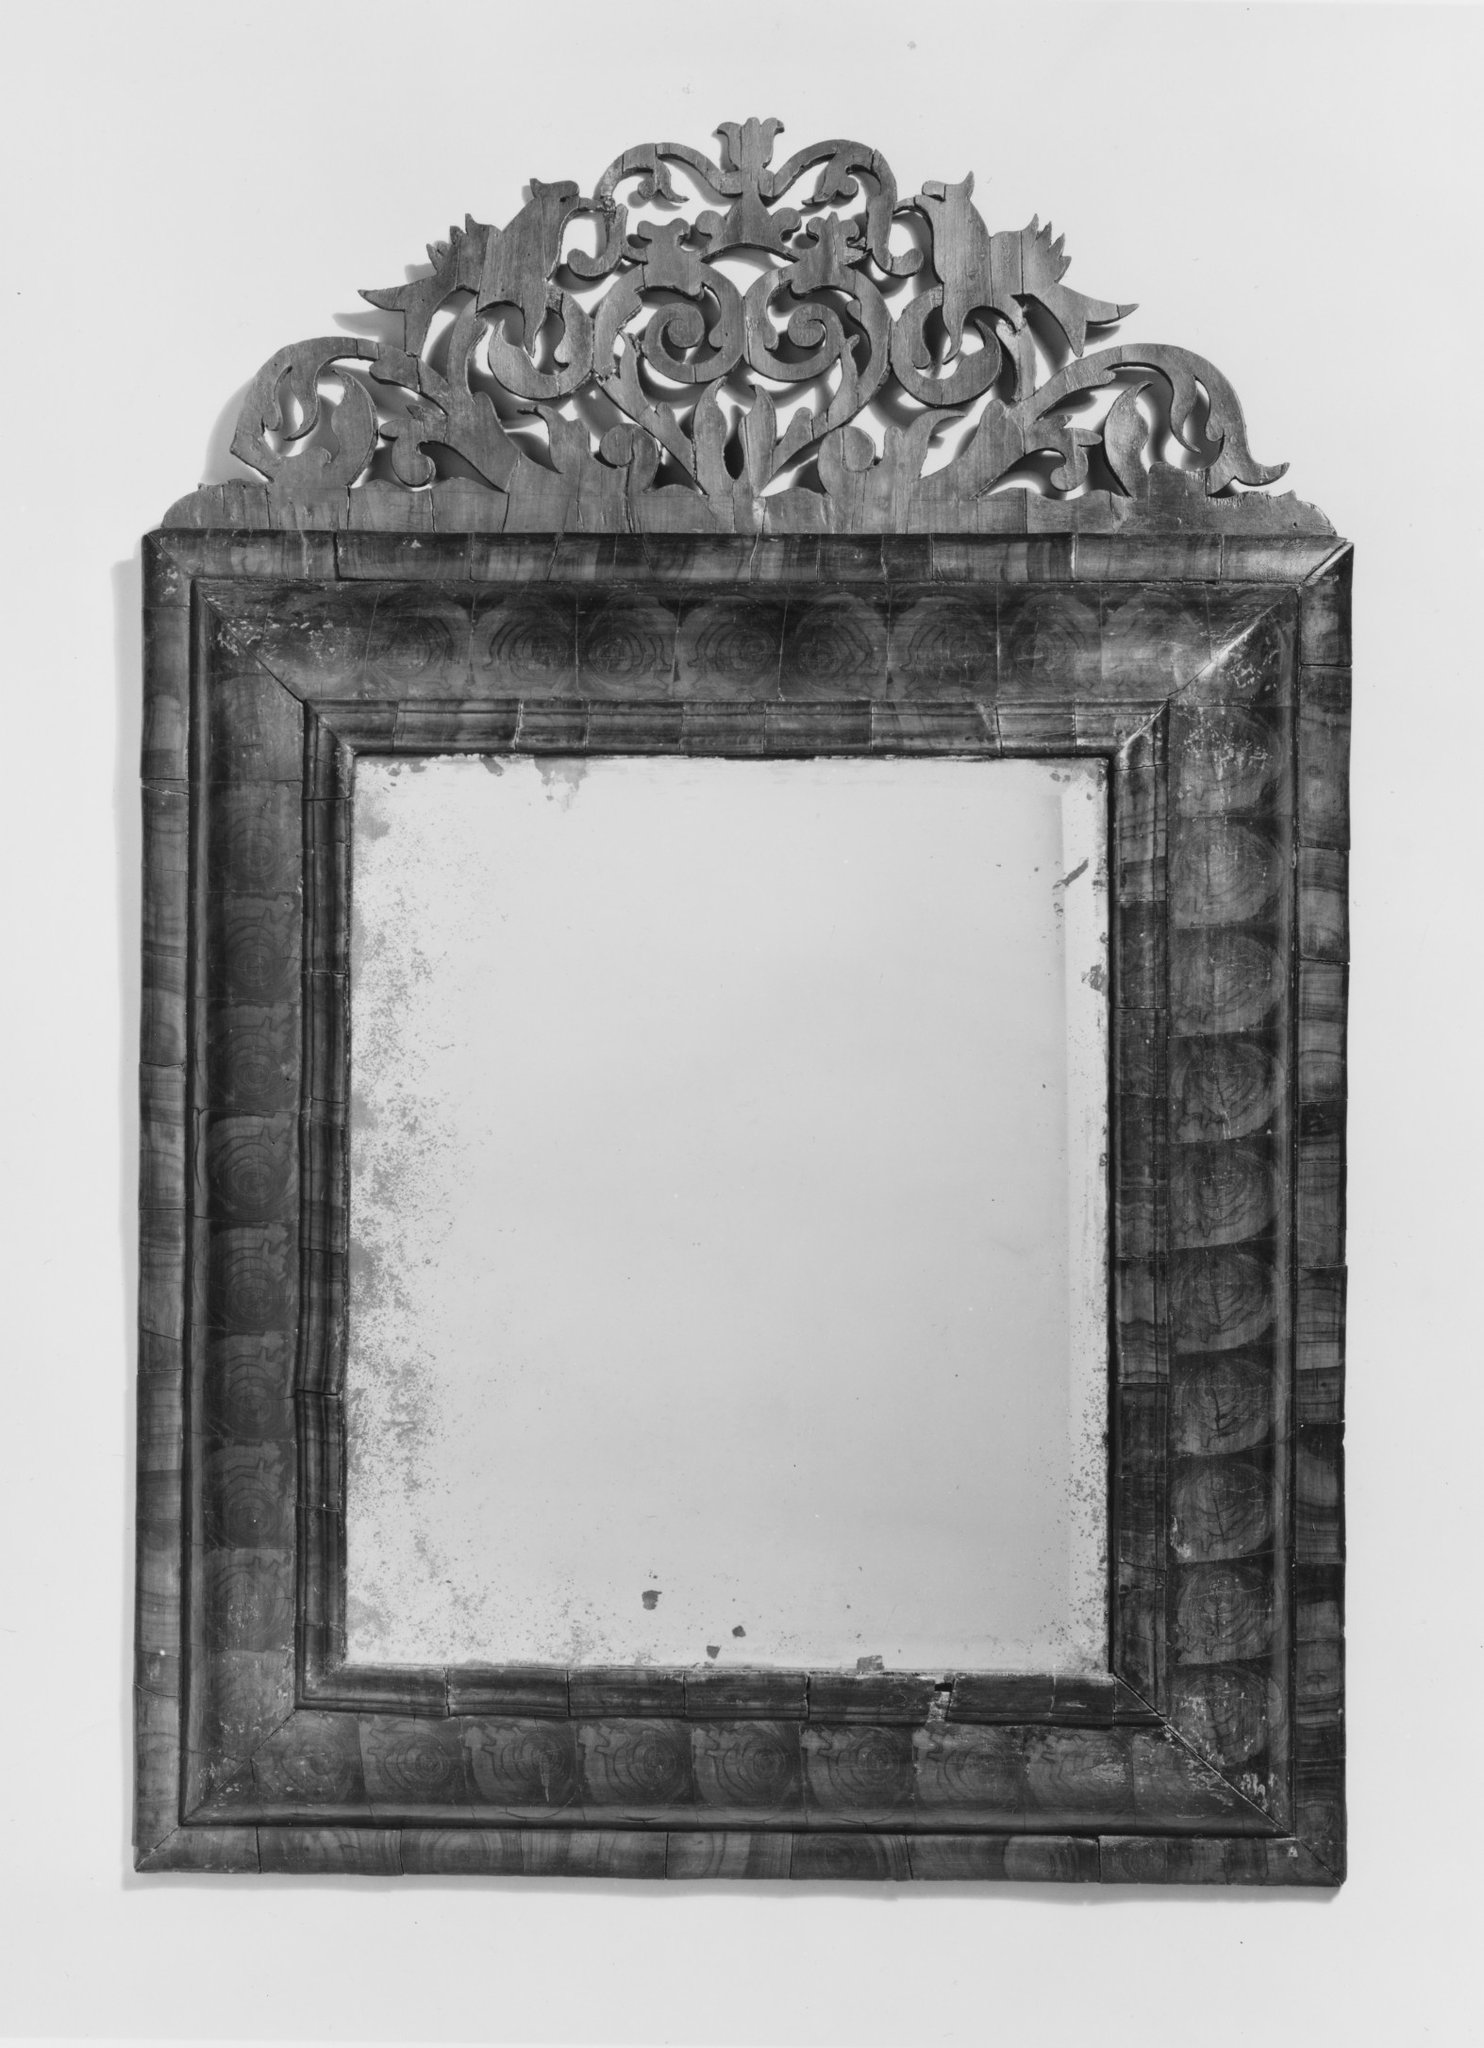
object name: looking glass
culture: british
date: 1685-1705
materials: glass, wood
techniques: veneering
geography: england